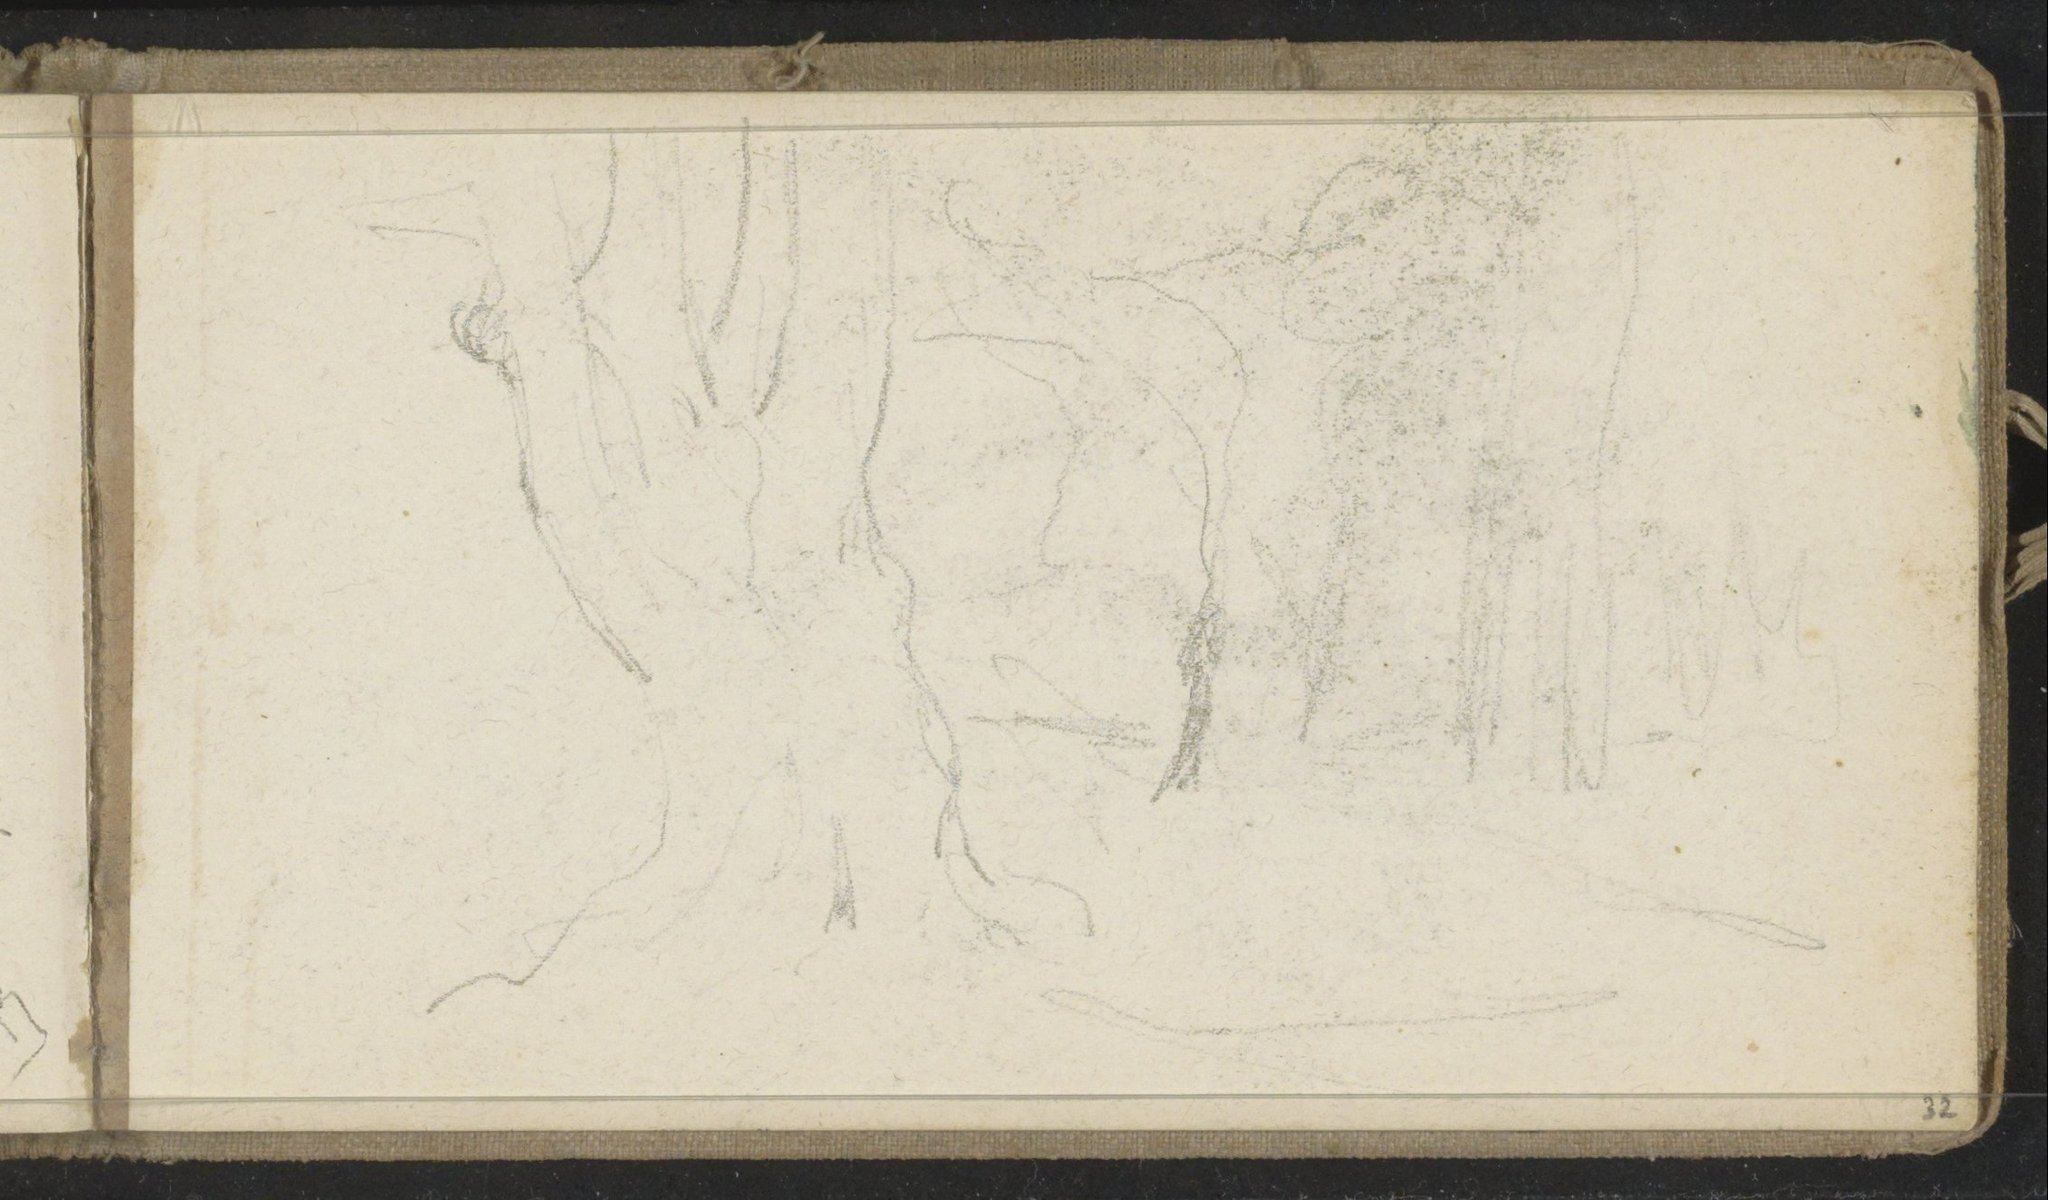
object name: sketchbook leaf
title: Bomen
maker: willem cornelis rip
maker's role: draughtsman, painter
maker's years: 1856-1922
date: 1895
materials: paper, pencil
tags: trees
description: Blad 32 recto uit een schetsboek met 39 bladen.